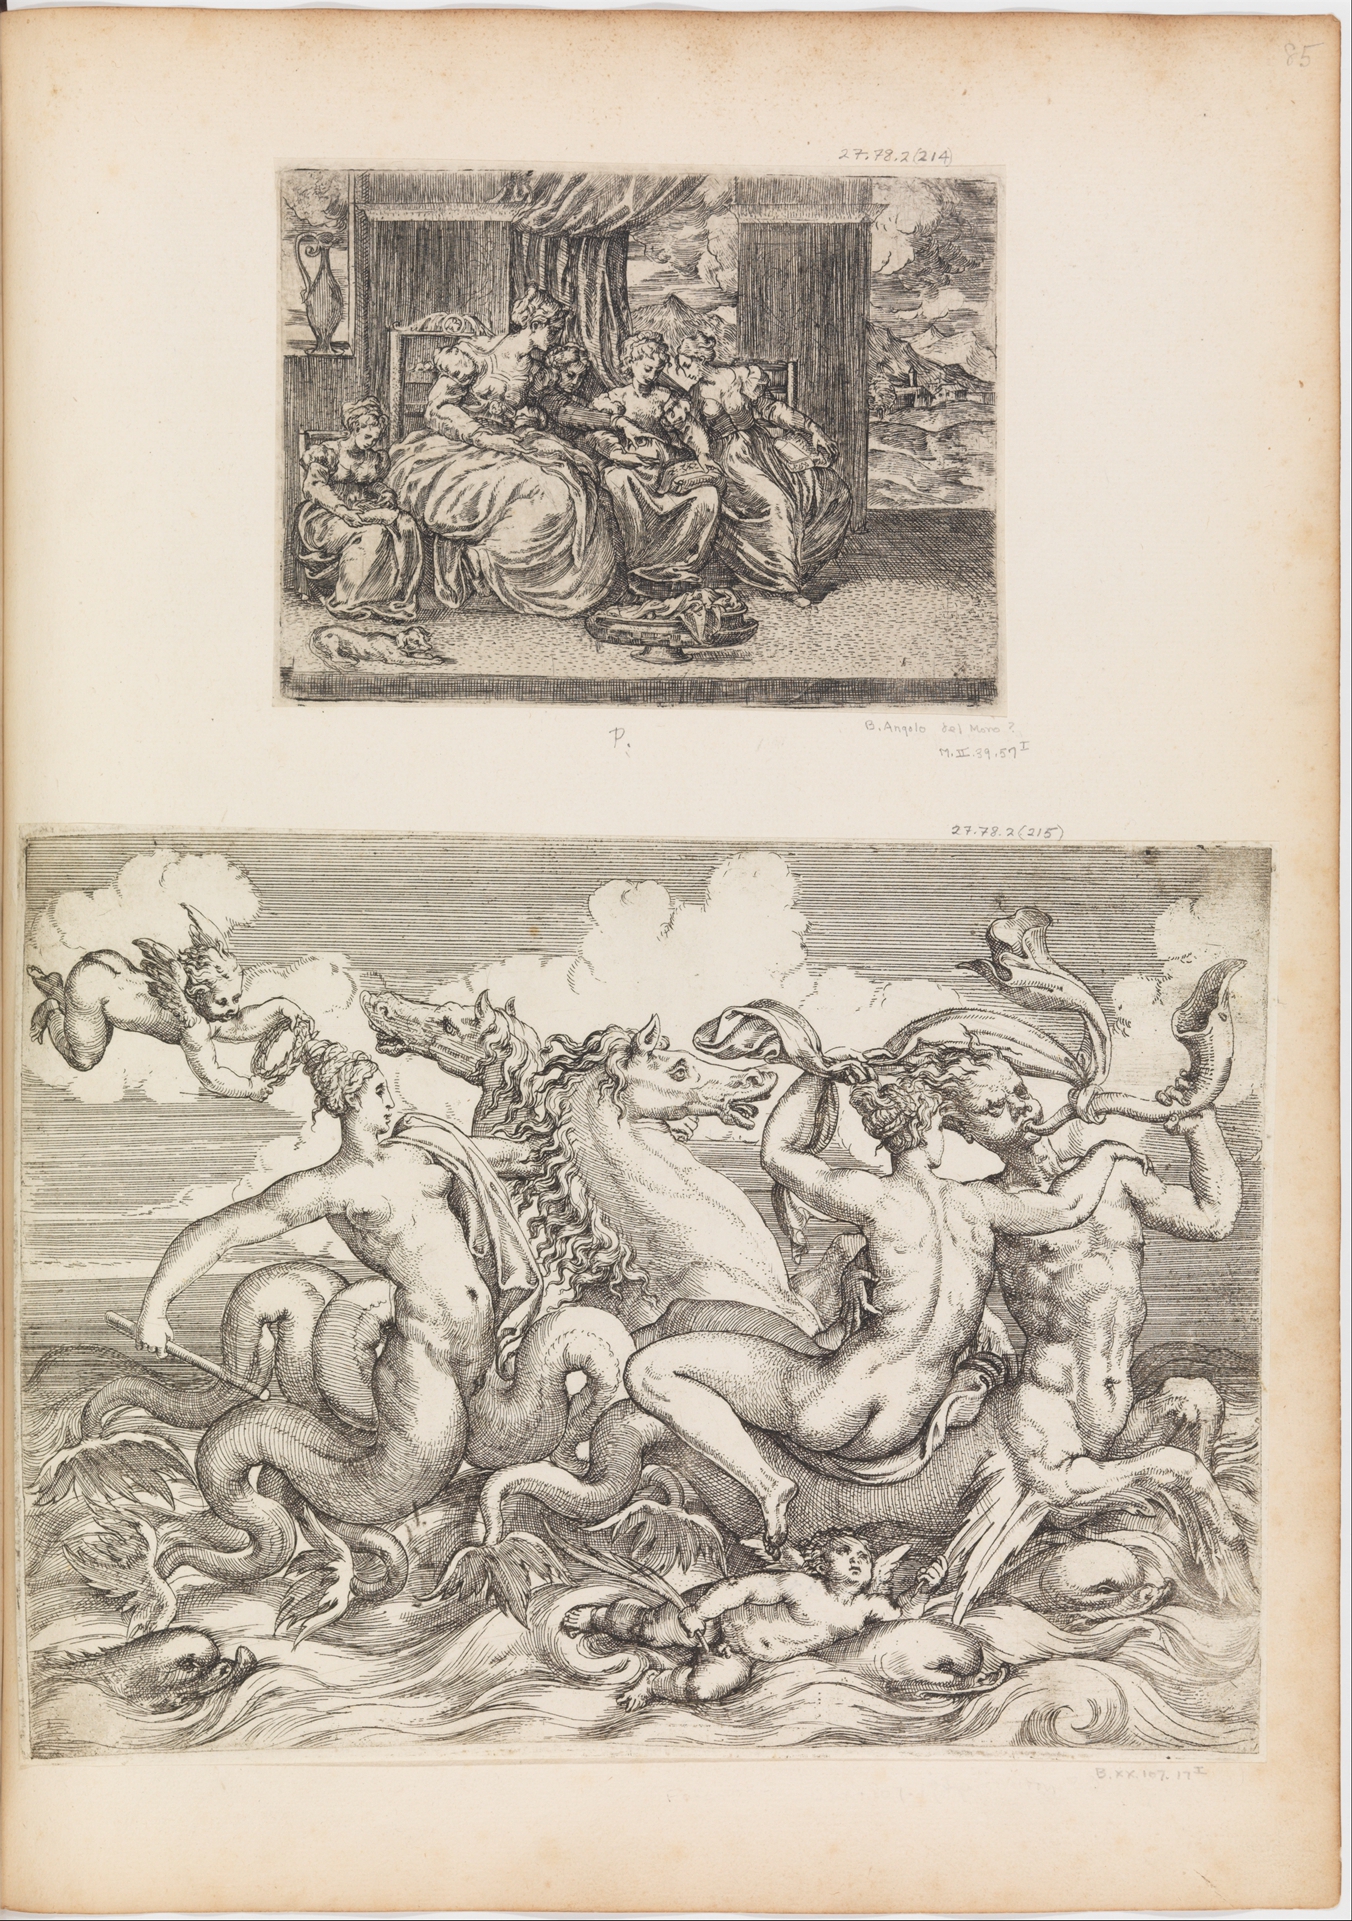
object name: print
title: The School of Needlework. A Woman Teaches Young Women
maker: battista angolo del moro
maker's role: artist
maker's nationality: italian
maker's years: 1515-1573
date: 1550-1600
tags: male nudes,women,female nudes,horses